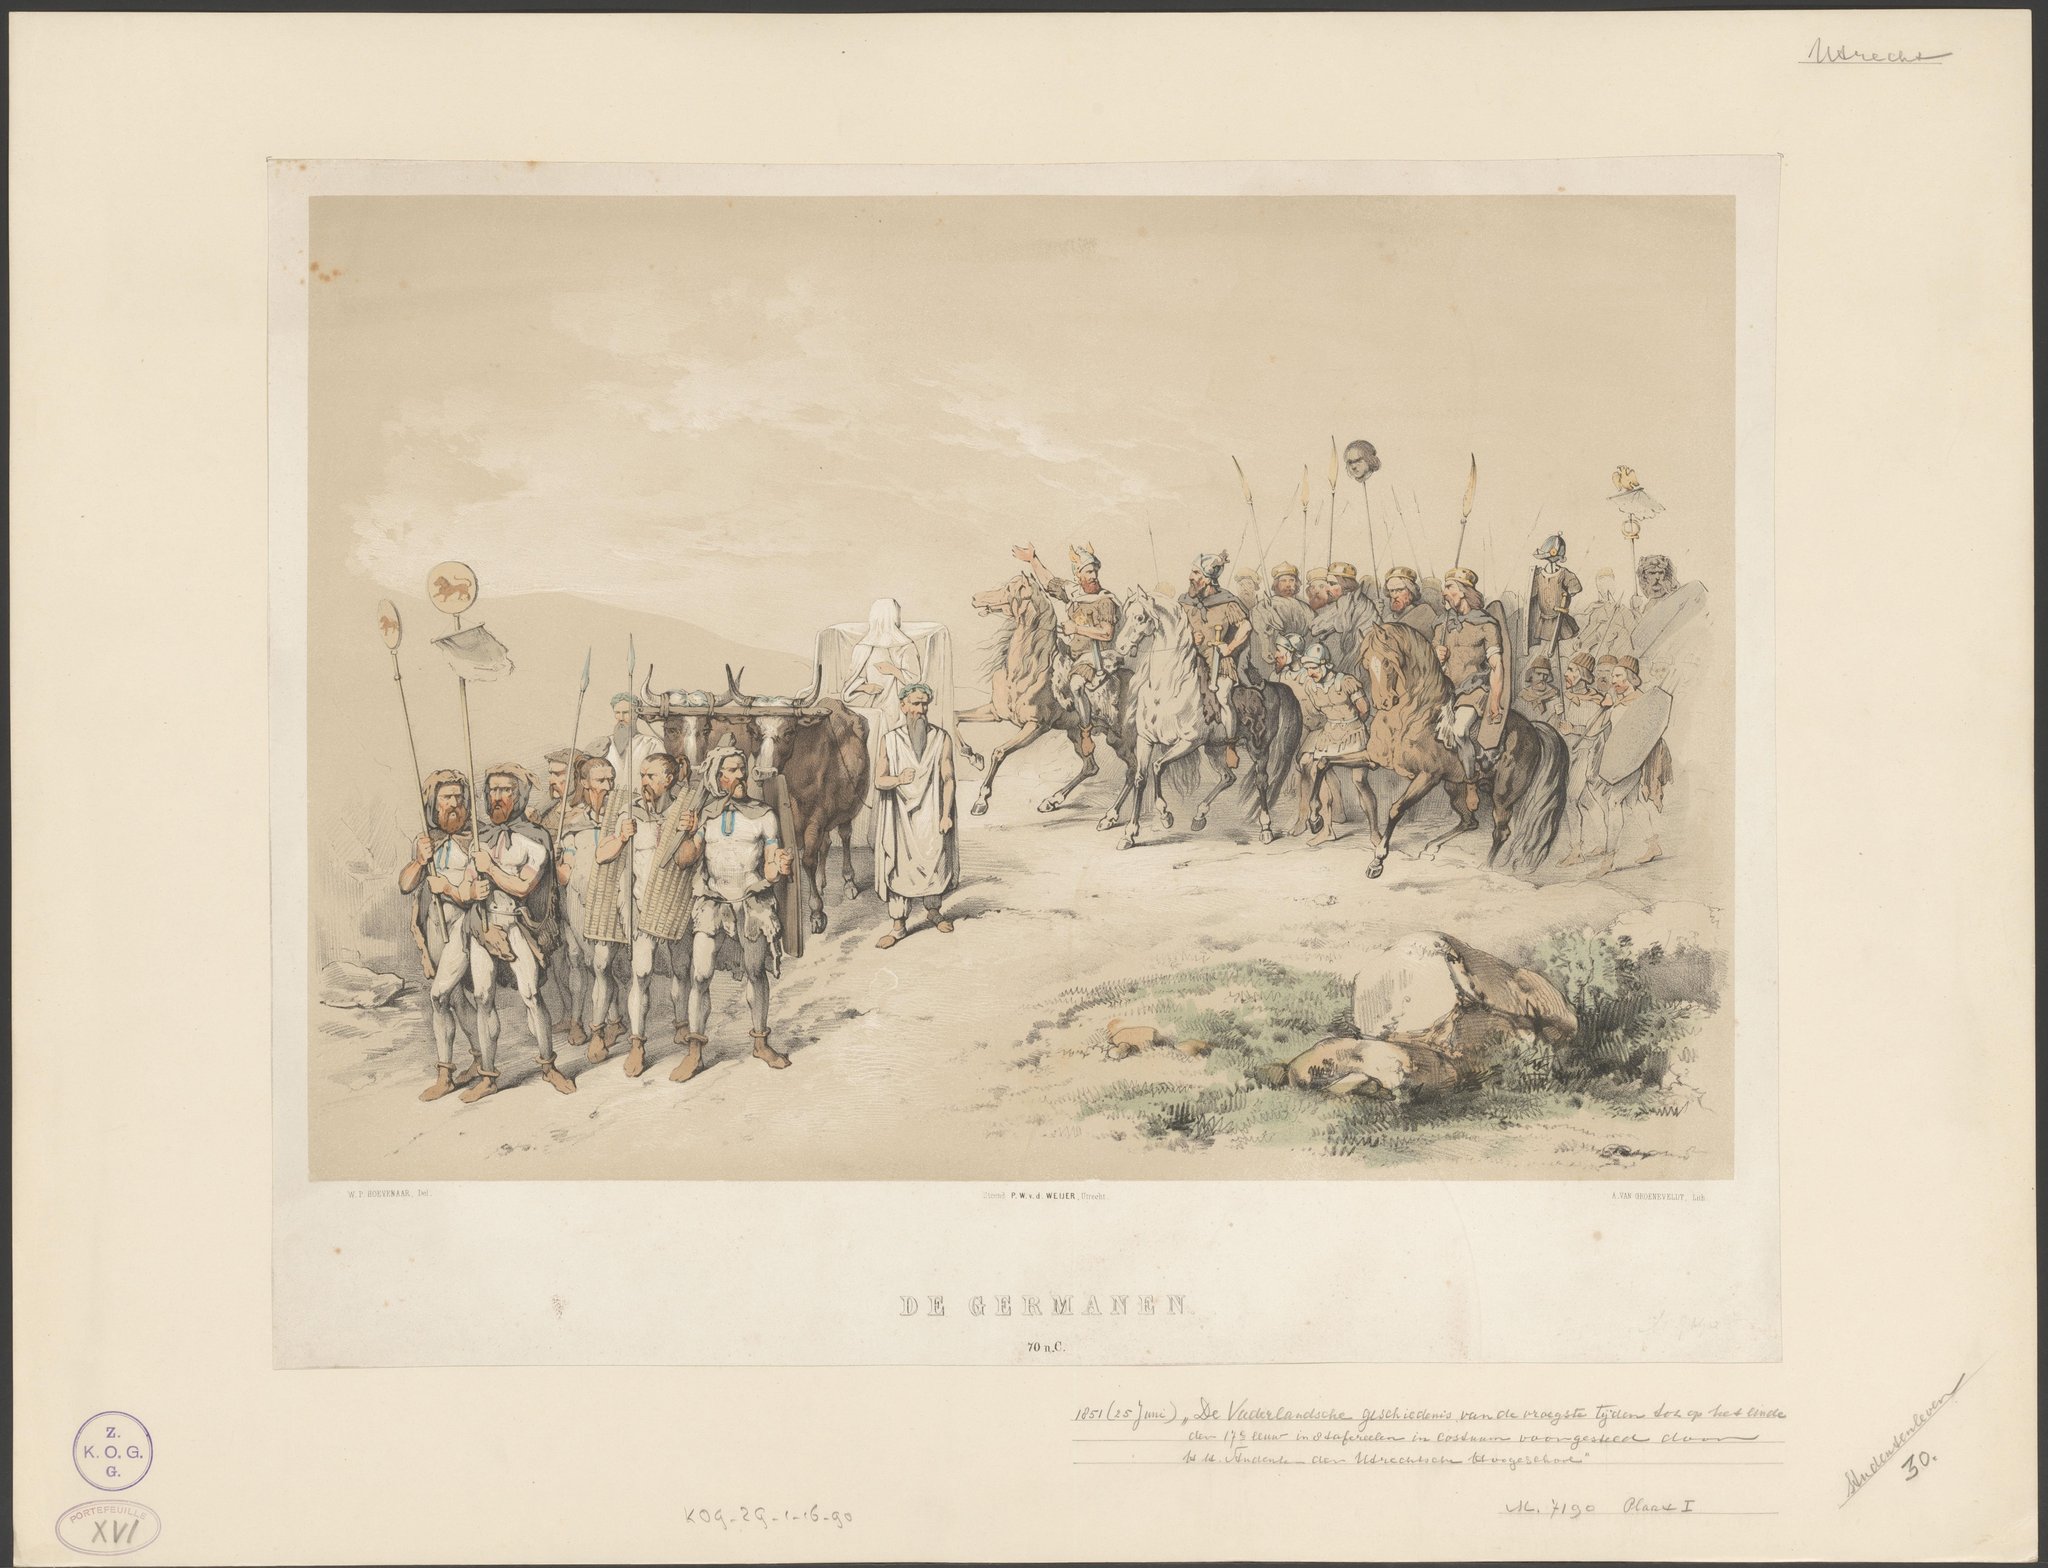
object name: print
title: Utrechtse maskerade van 1851: Germanen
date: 1851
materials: paper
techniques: hand coloring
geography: utrecht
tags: students' pageant, costumes used in pageants, utrecht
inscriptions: stamp, collector's mark: Lugt 1641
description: Prent uit een serie van acht prenten en acht zangen van de maskerade van de Utrechtse studenten, 25 juni 1851. De maskerade verbeeldt in taferelen acht episodes uit de vaderlandse geschiedenis.